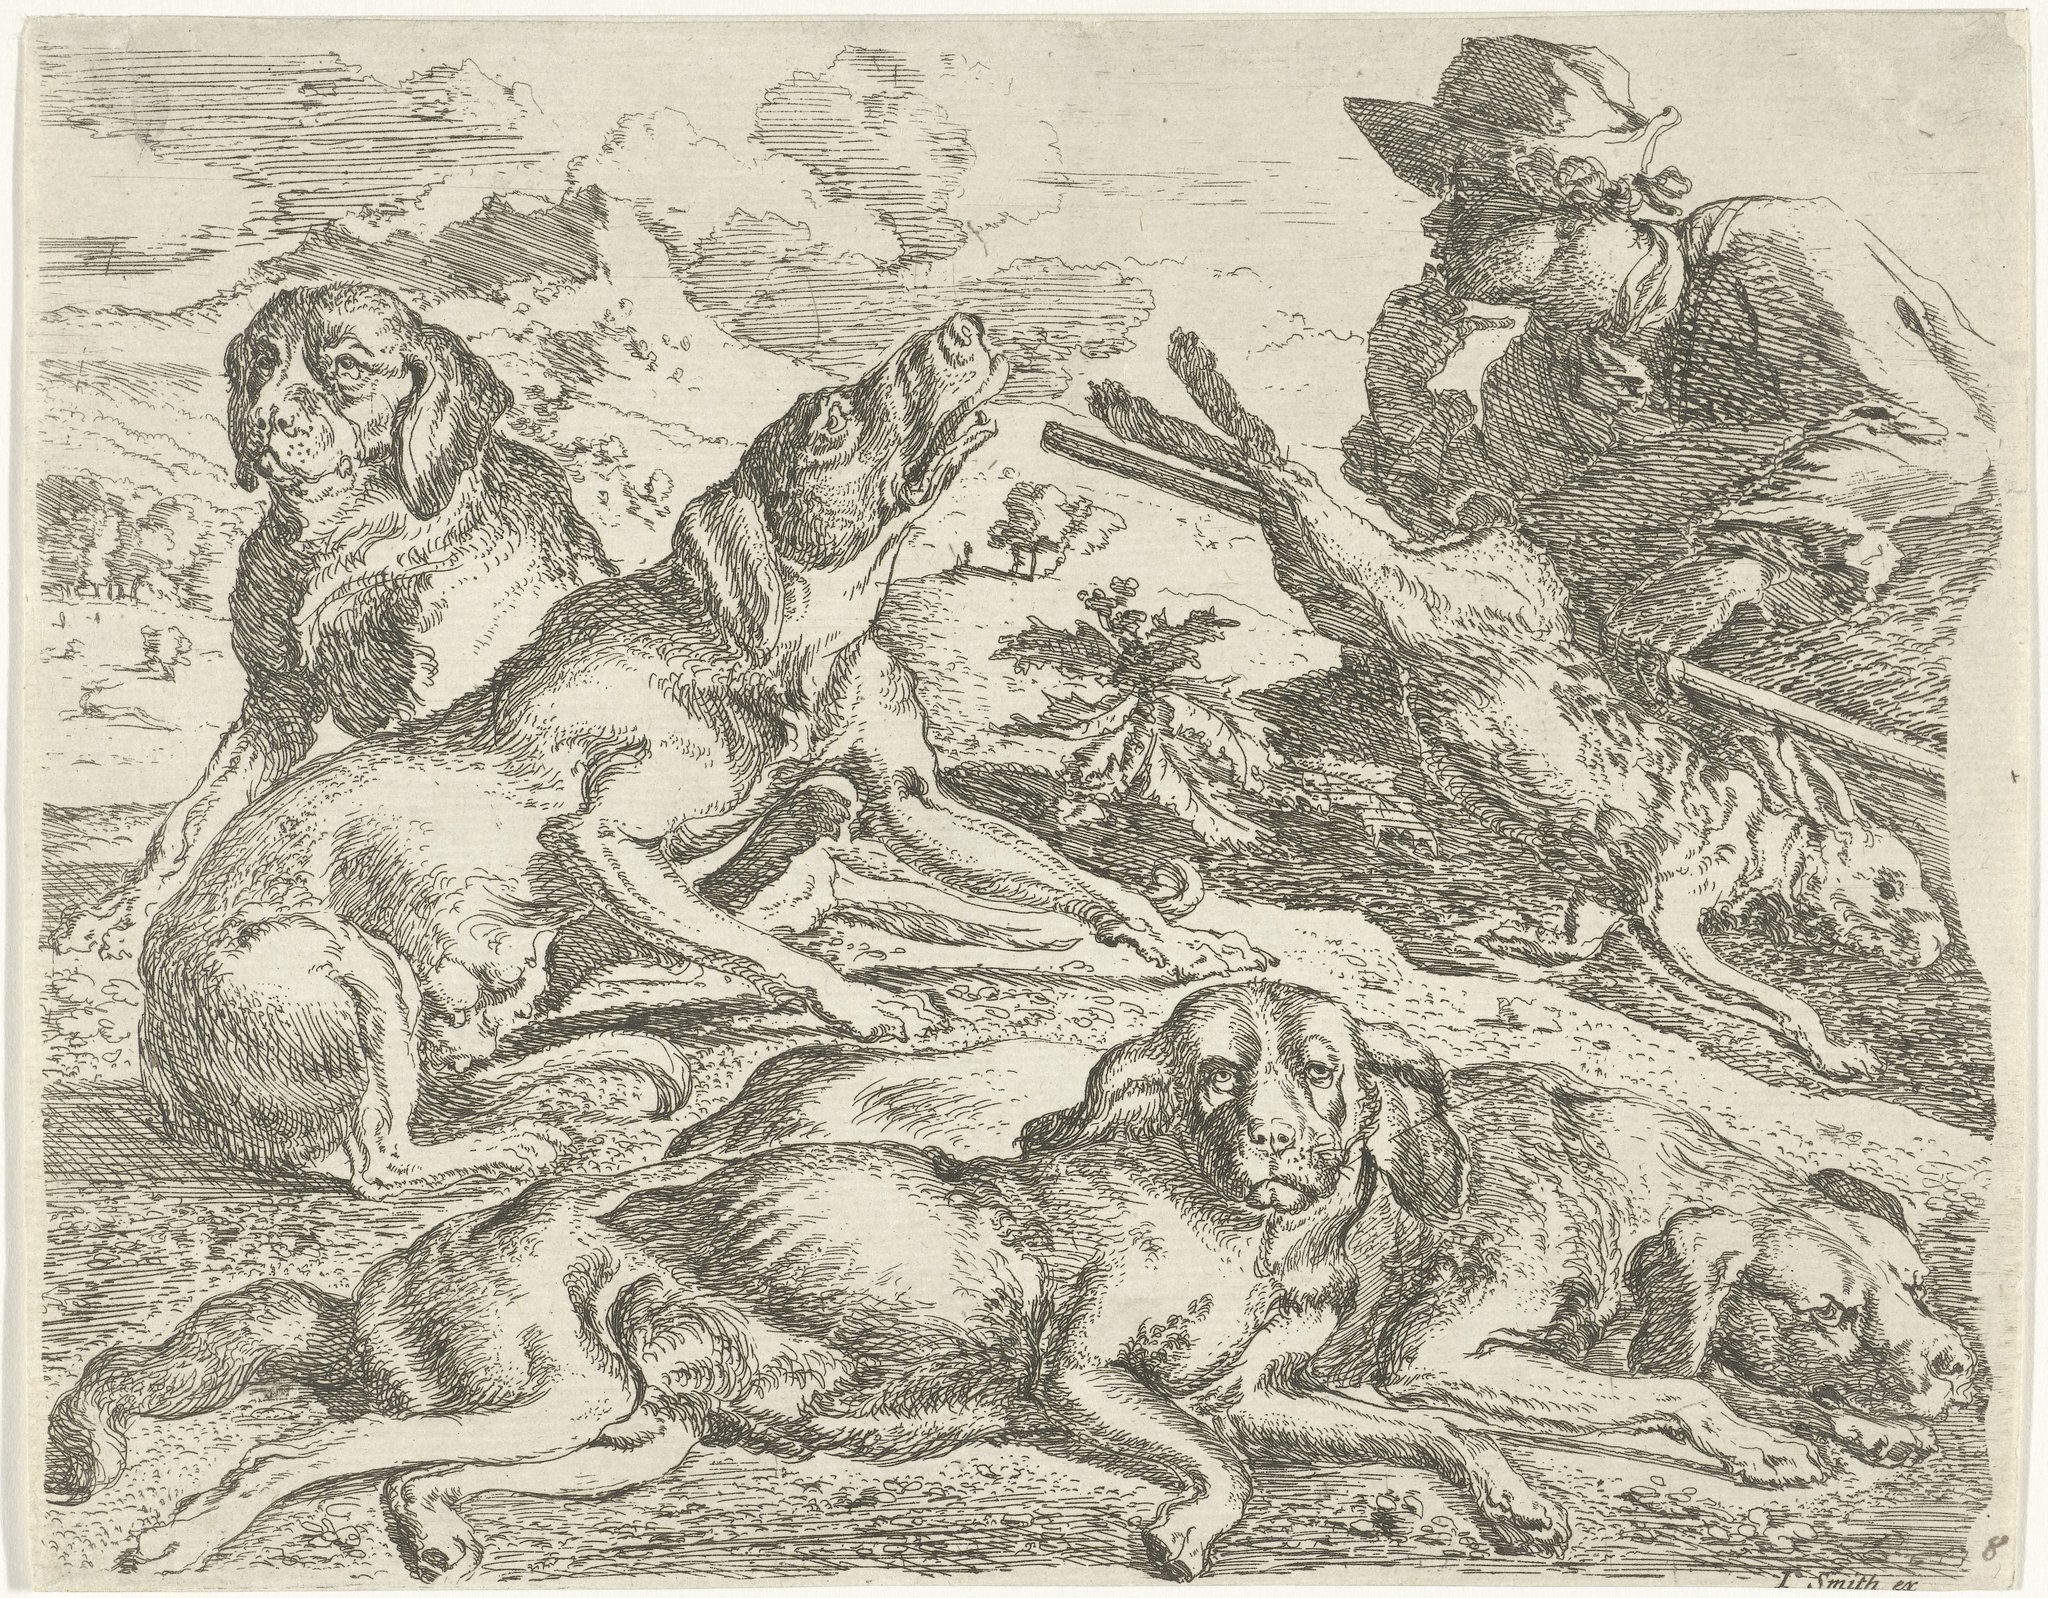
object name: print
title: Vier honden, een jager en een haas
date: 1671-1691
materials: paper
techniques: etching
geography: england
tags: hunter, dog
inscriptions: collector's mark: Lugt 2228